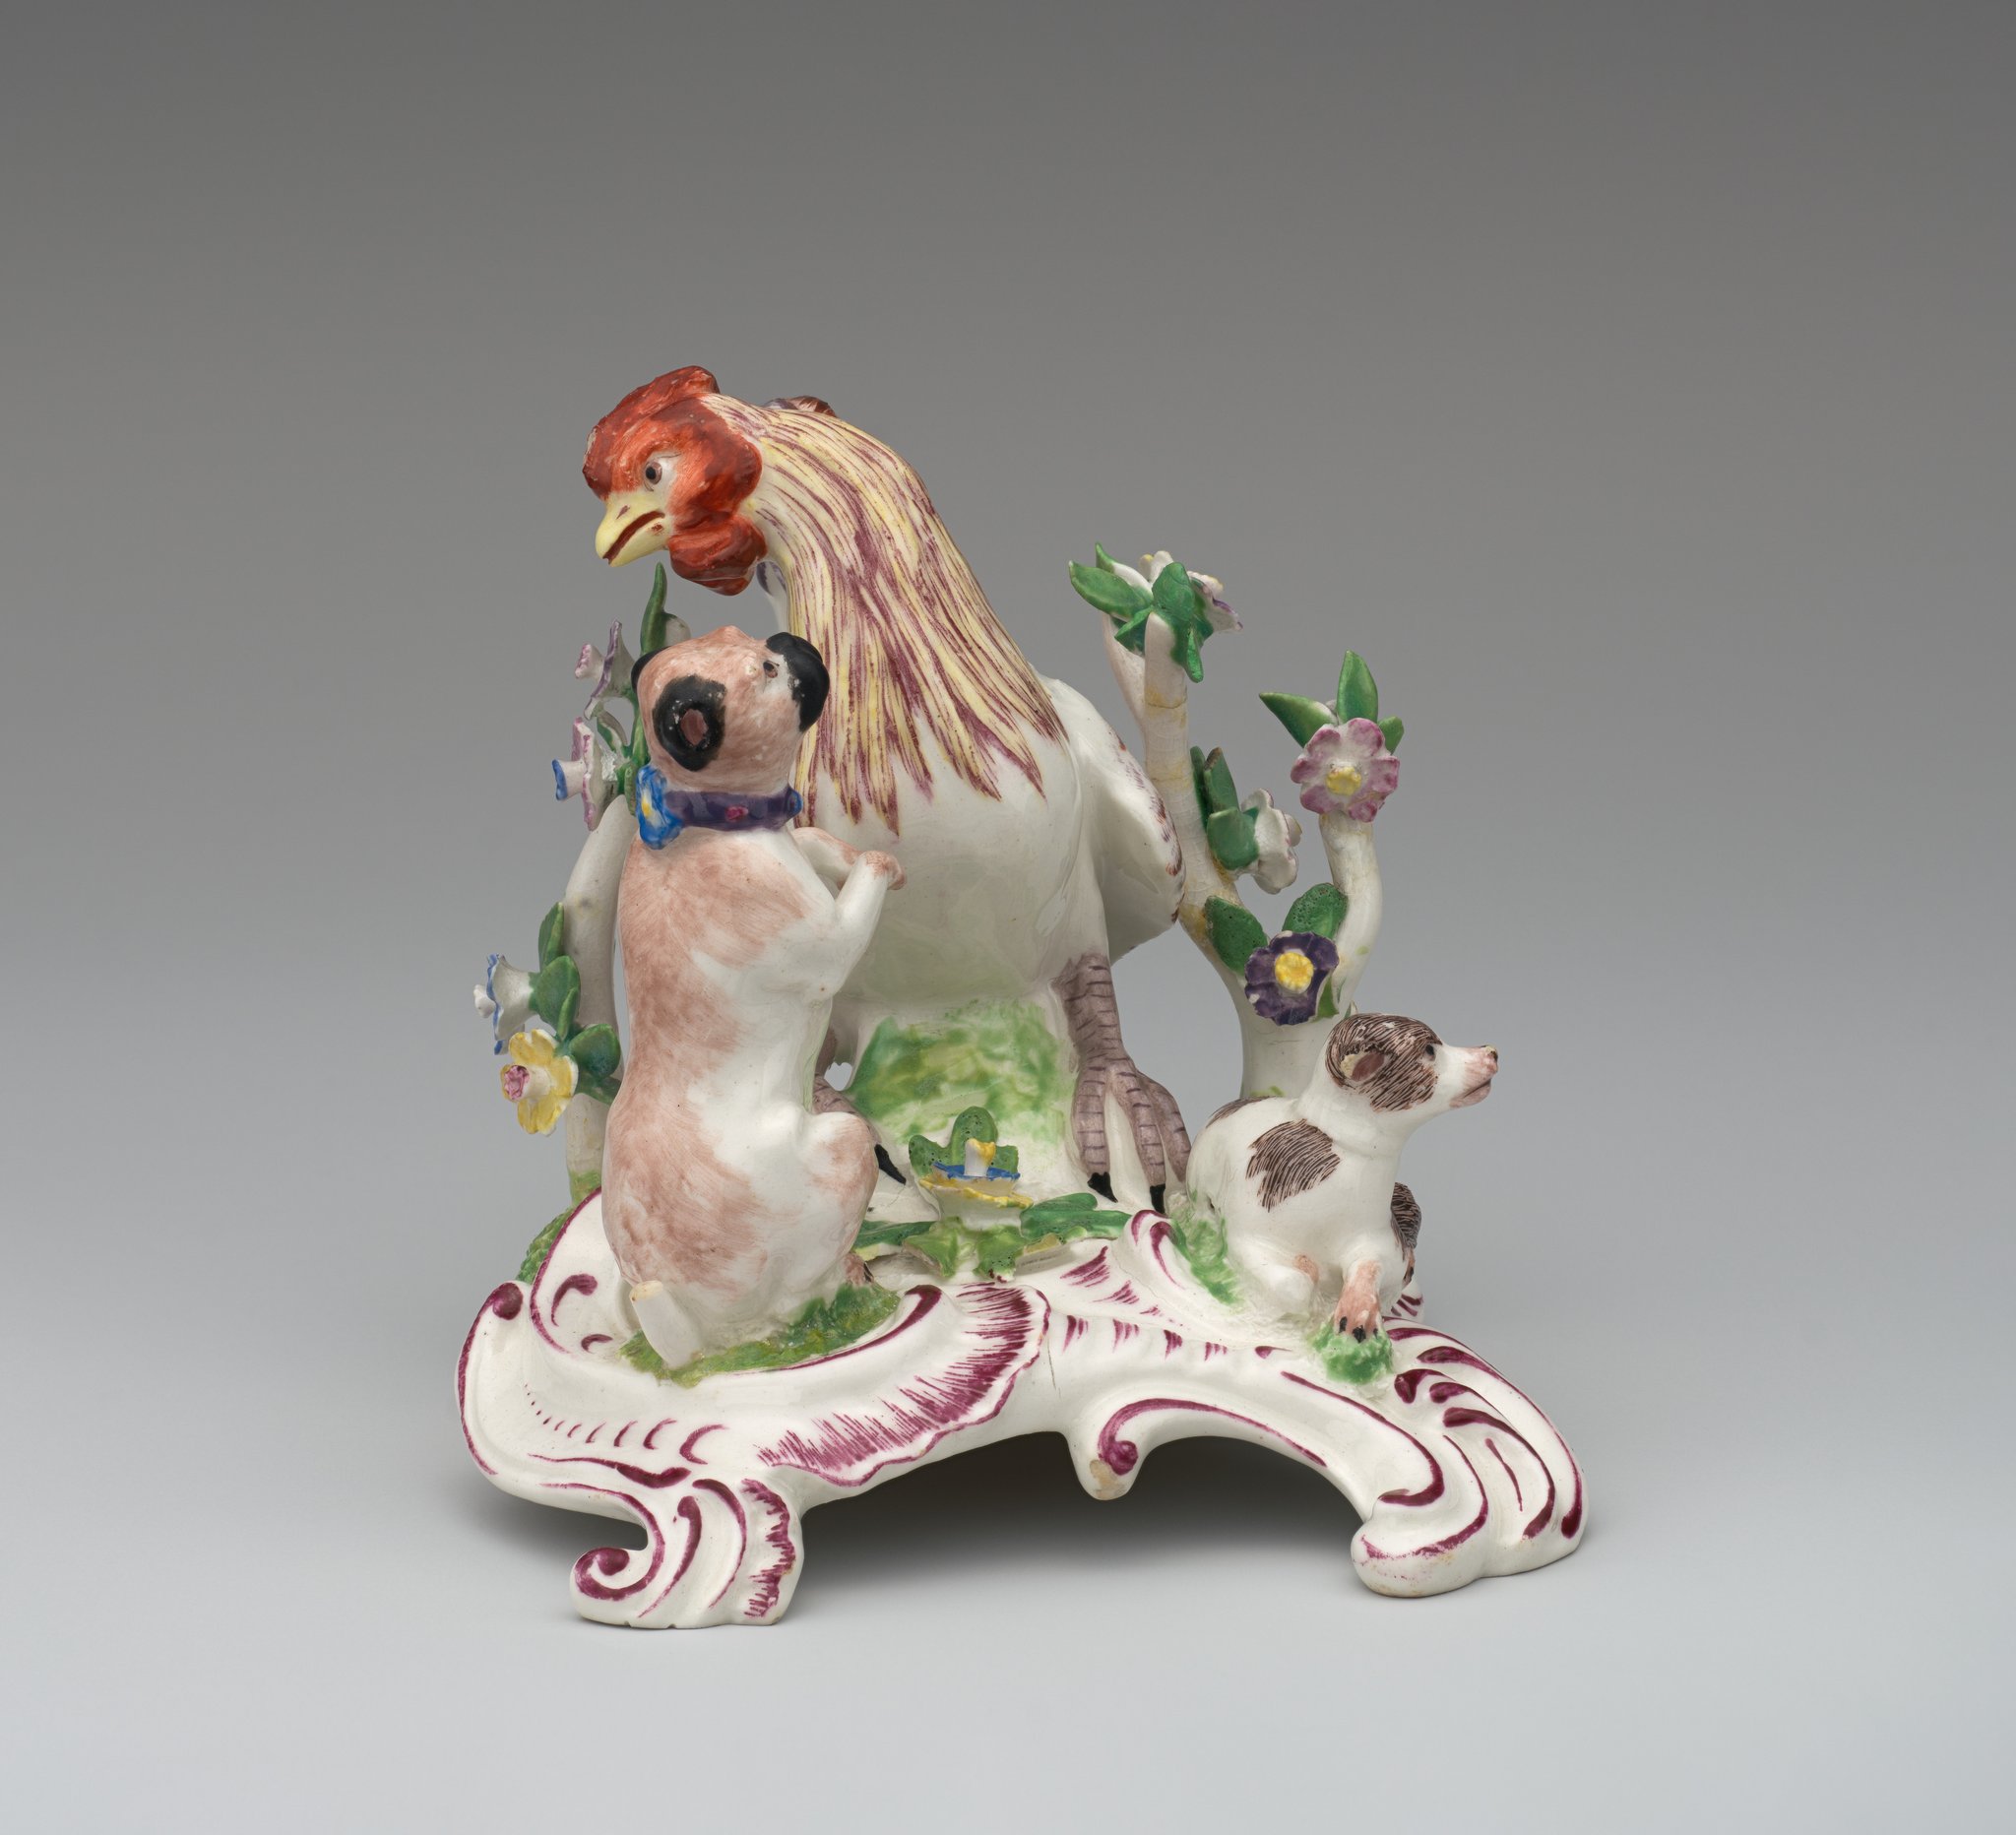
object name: group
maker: bow porcelain factory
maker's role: factory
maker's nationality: british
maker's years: 1747-1776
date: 1755-1760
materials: soft paste porcelain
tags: roosters,dogs